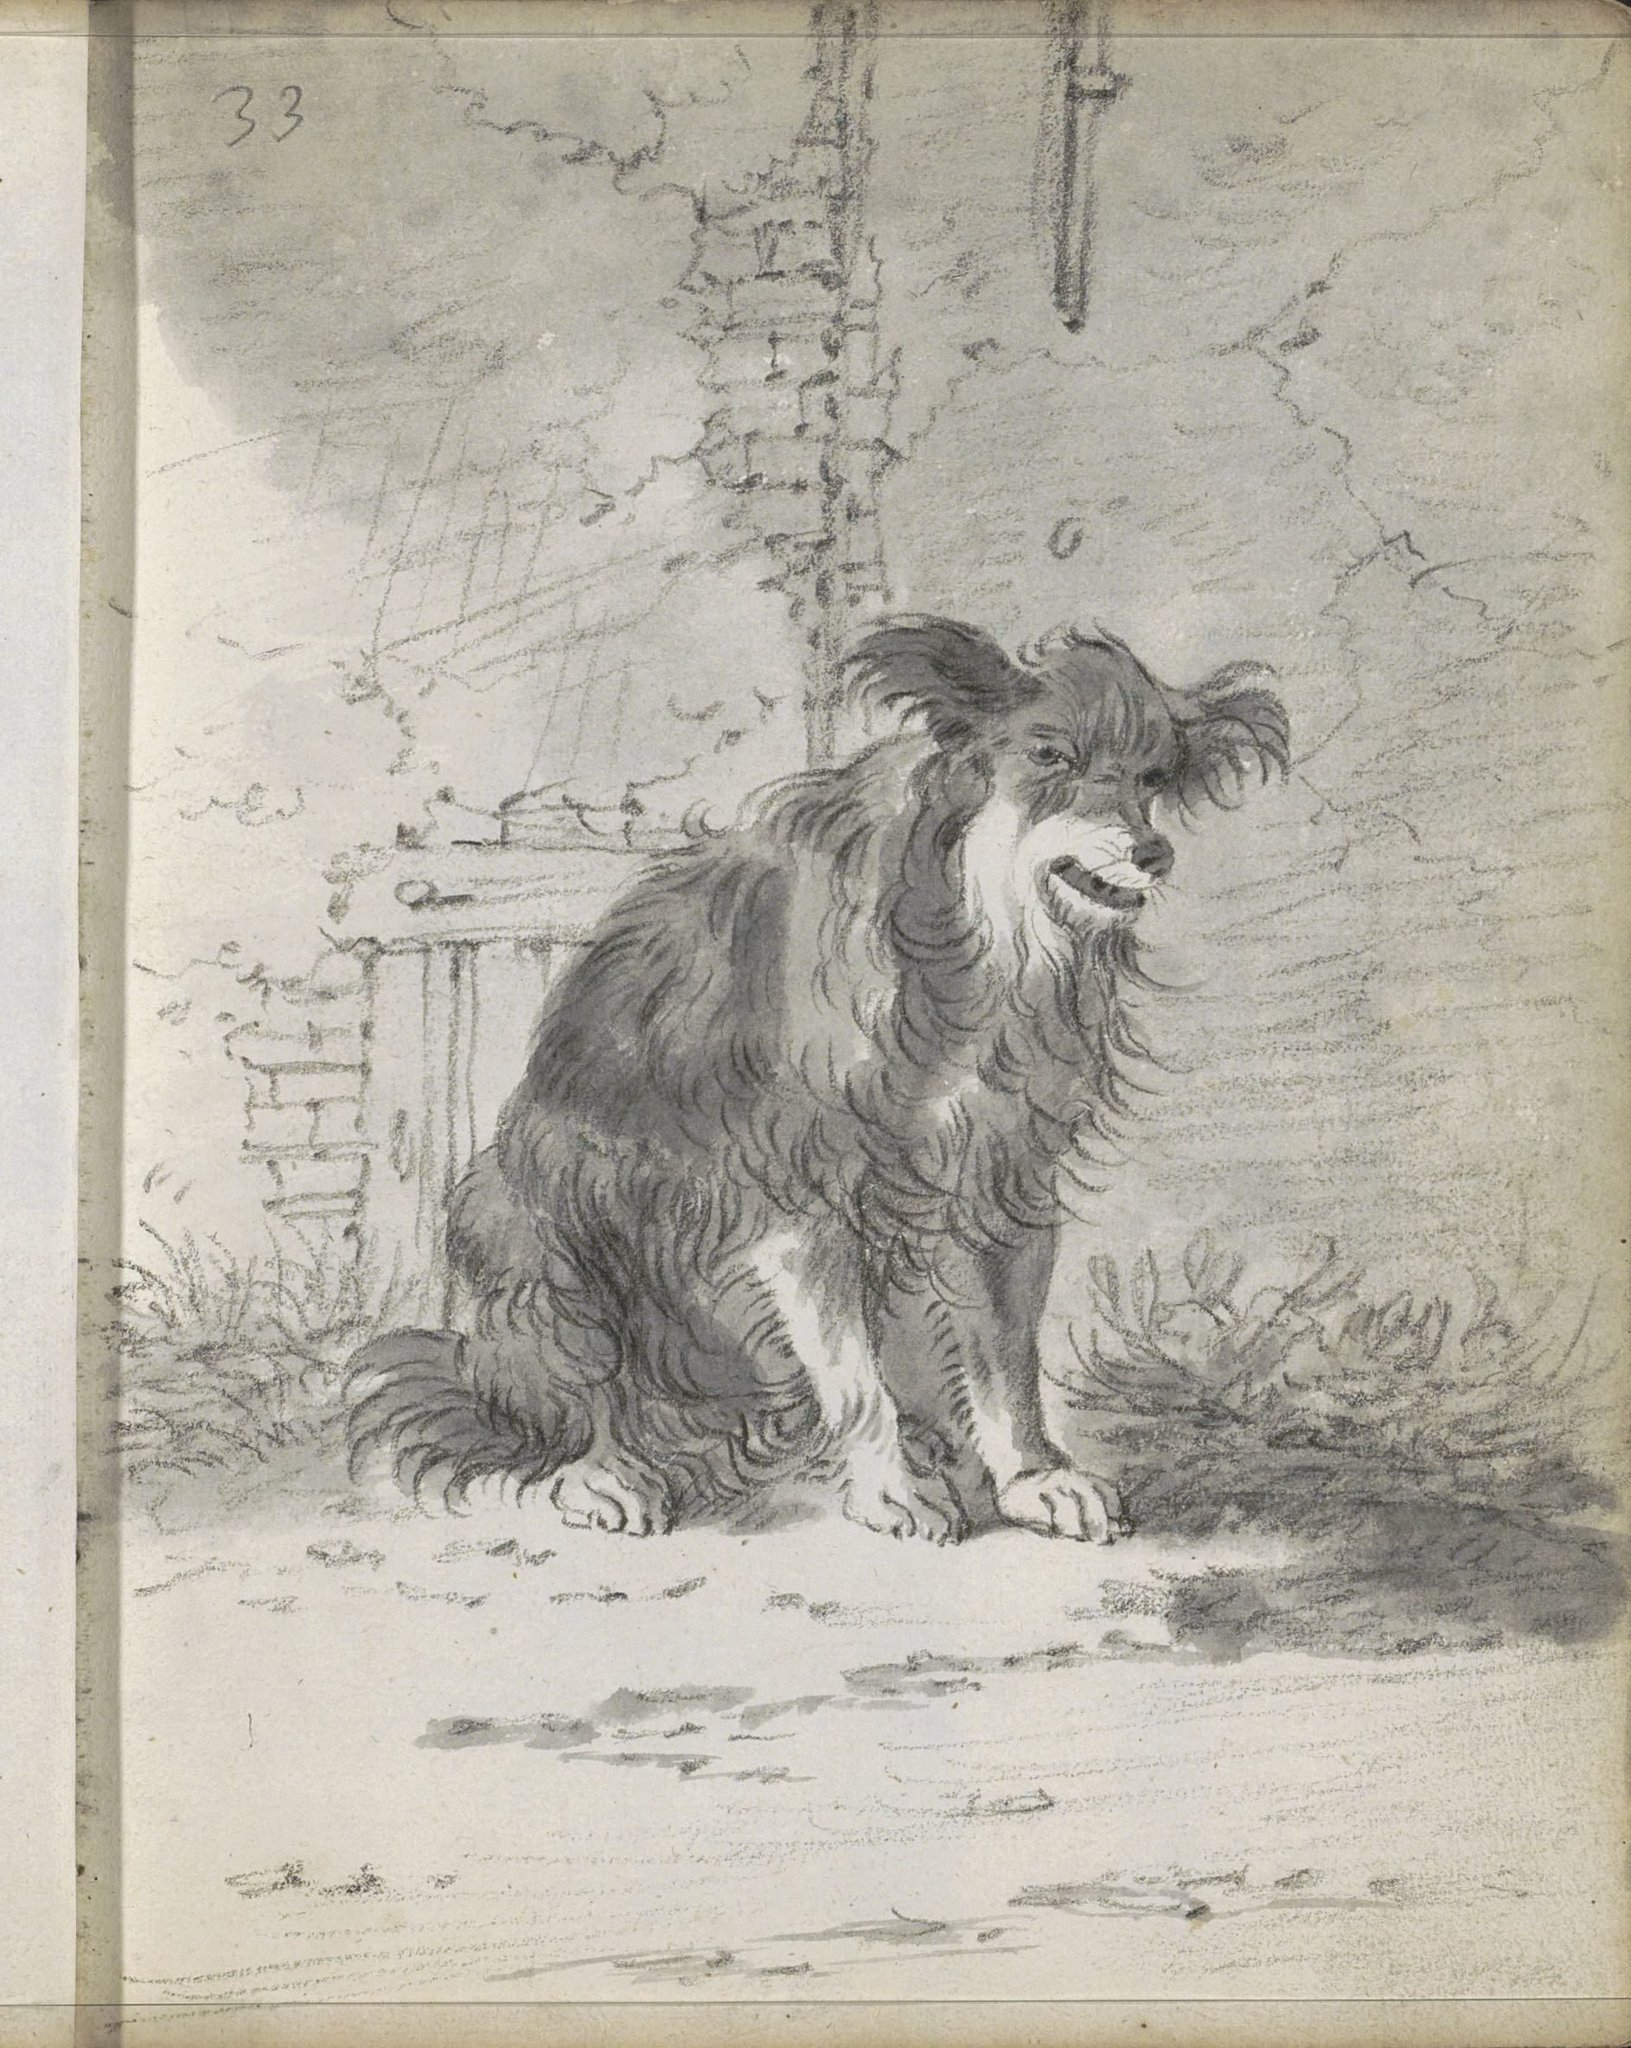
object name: sketchbook leaf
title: Zittende hond bij een muur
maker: cornelis saftleven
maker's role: draughtsman, painter, print maker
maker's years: 1607-1681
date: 1666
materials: chalk, ink, paper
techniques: brush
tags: fence, wall, paling, dog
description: Blad 33 recto uit een schetsboek met 49 bladen.